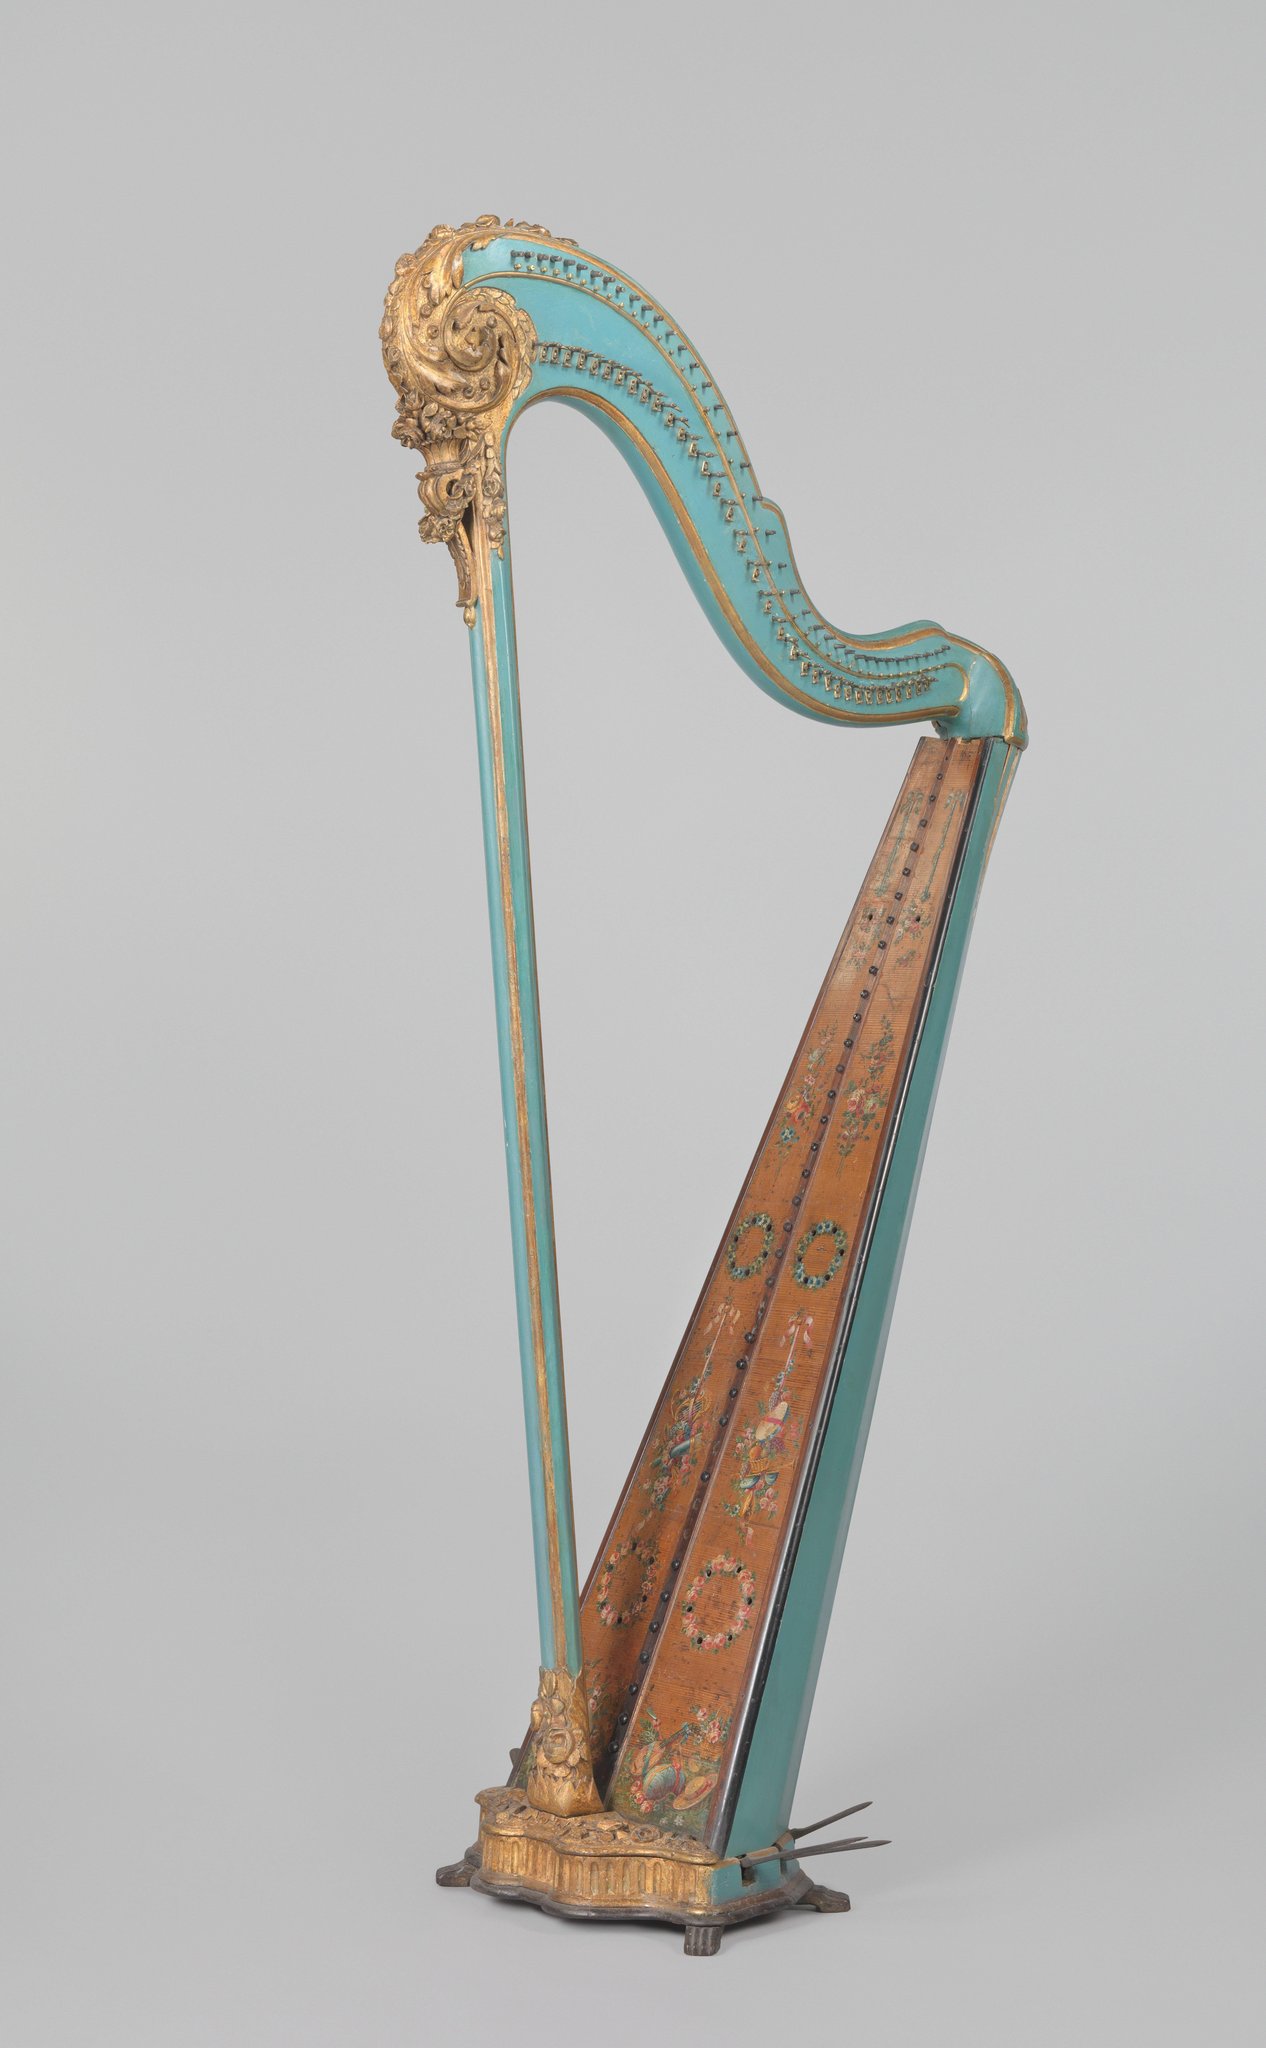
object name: harp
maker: Anonymous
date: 1780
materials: wood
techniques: gilding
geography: france